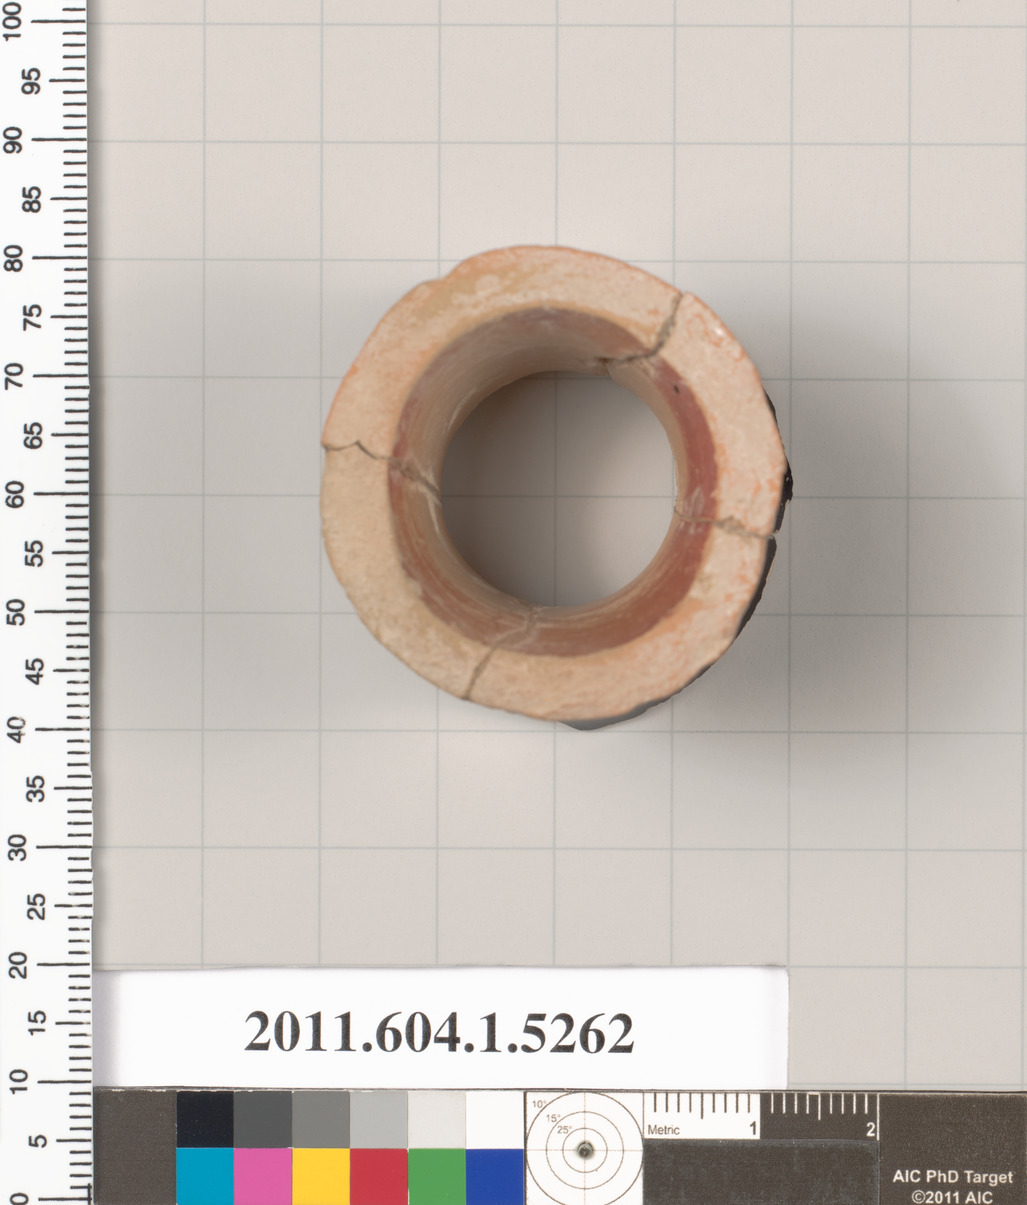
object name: kylix fragment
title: Terracotta fragment of a kylix (drinking cup)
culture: greek, attic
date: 534-501 BCE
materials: terracotta